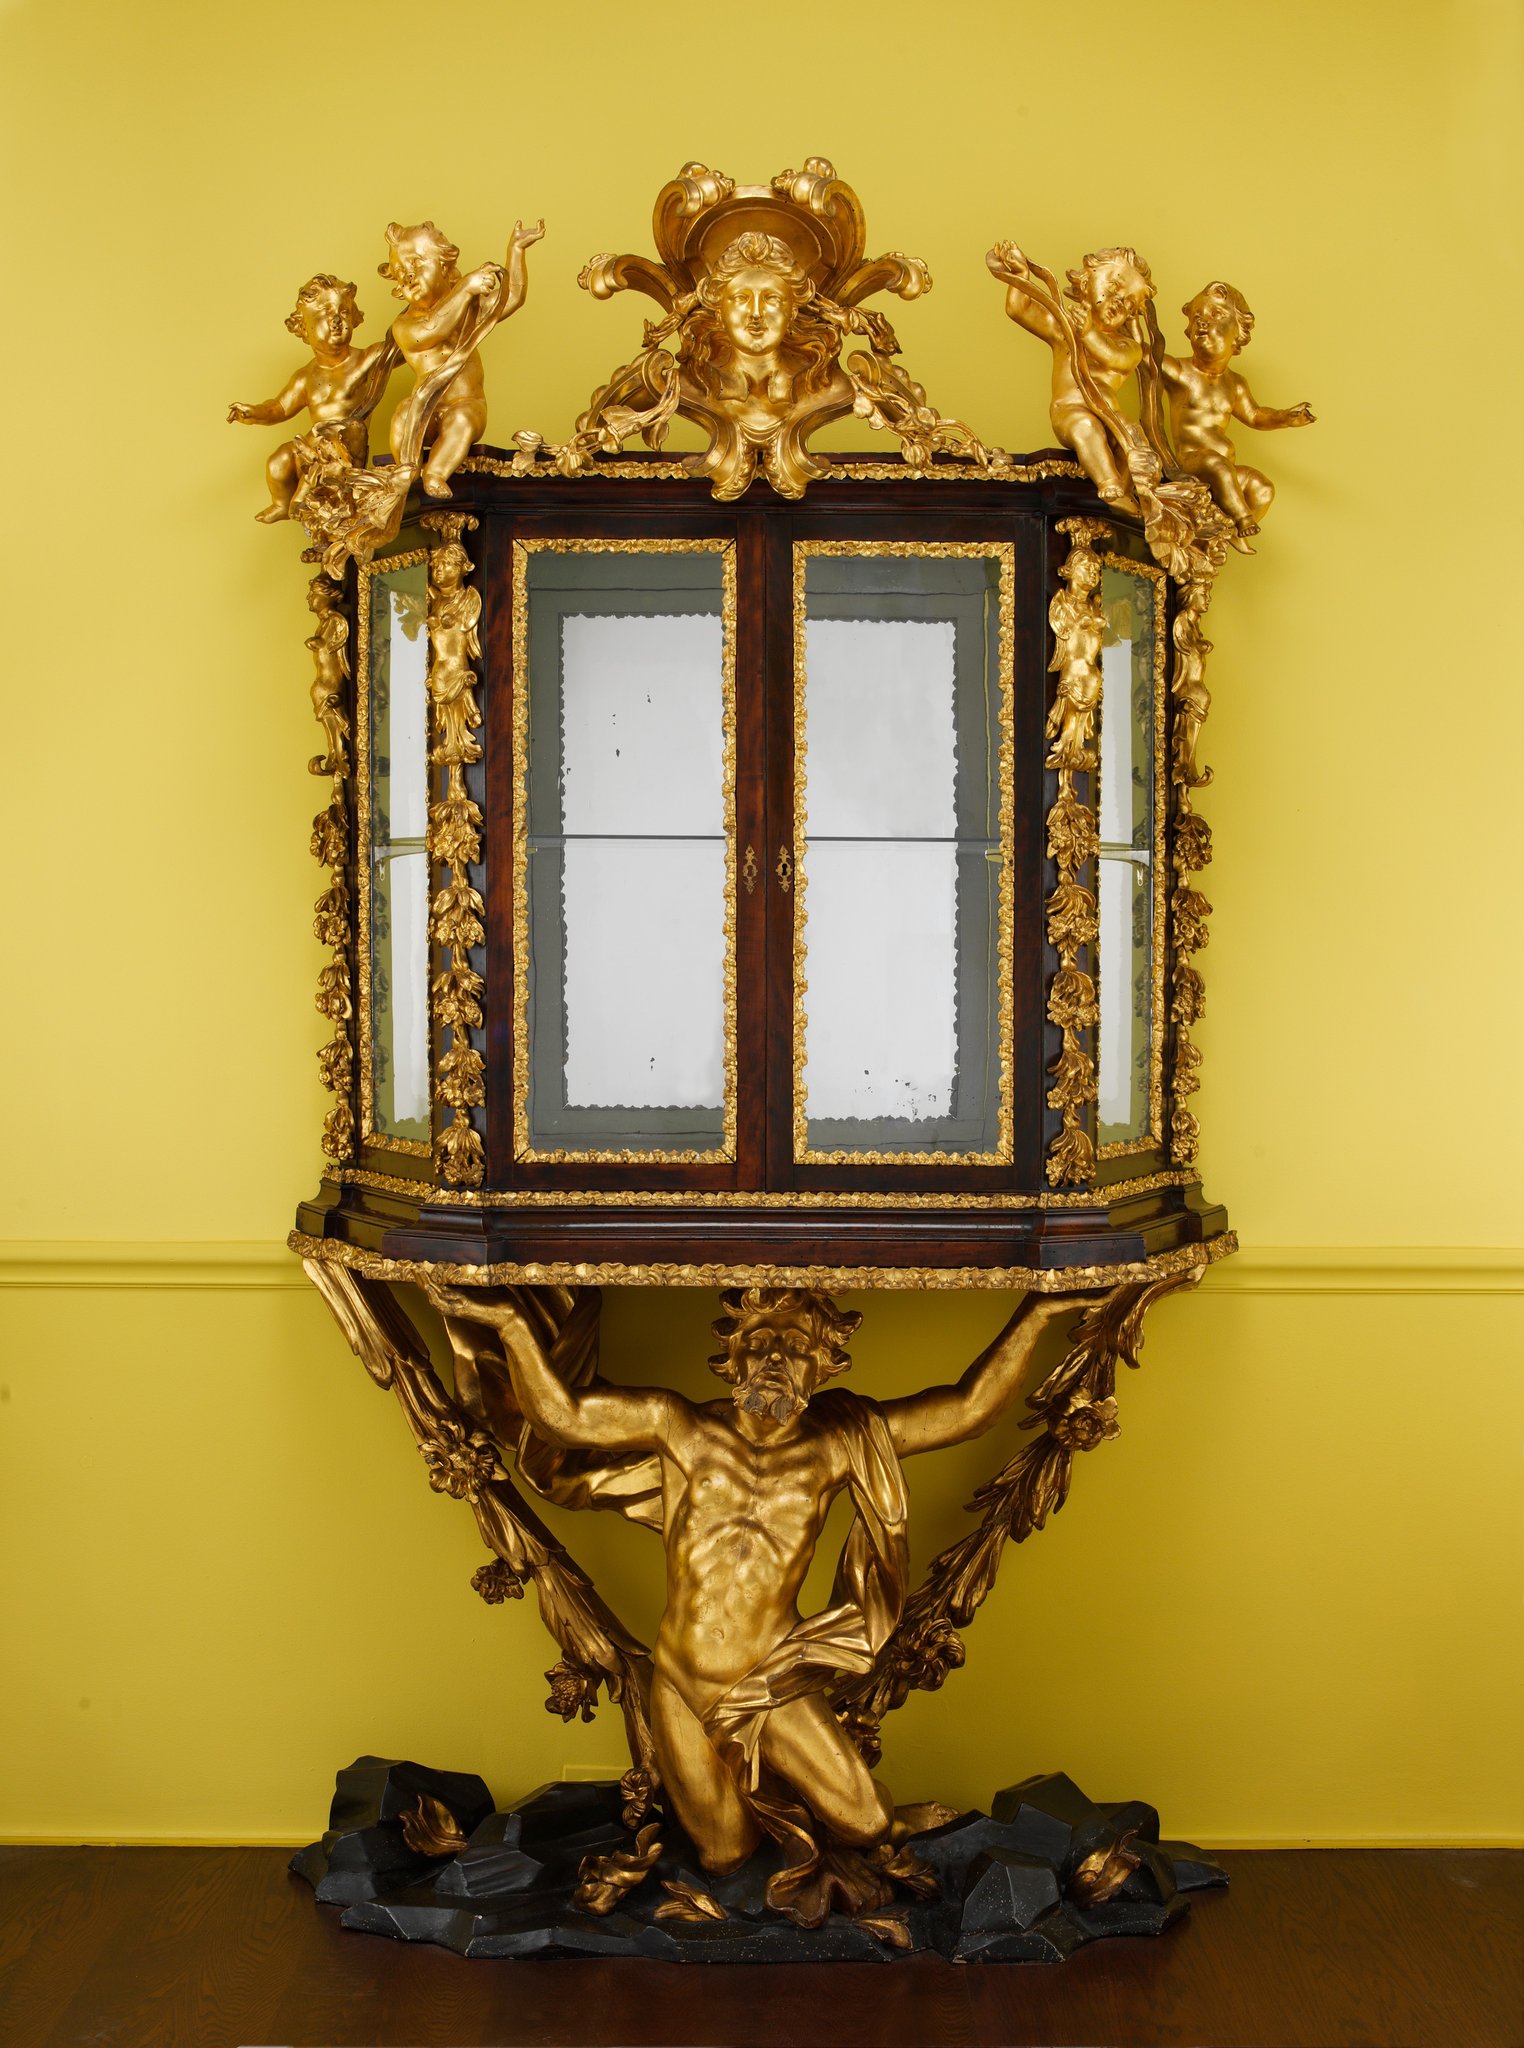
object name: showcase on stand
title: Showcase on stand (Scarabattola)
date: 1667-1700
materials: glass, wood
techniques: carving, gilding, painting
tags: men,putti